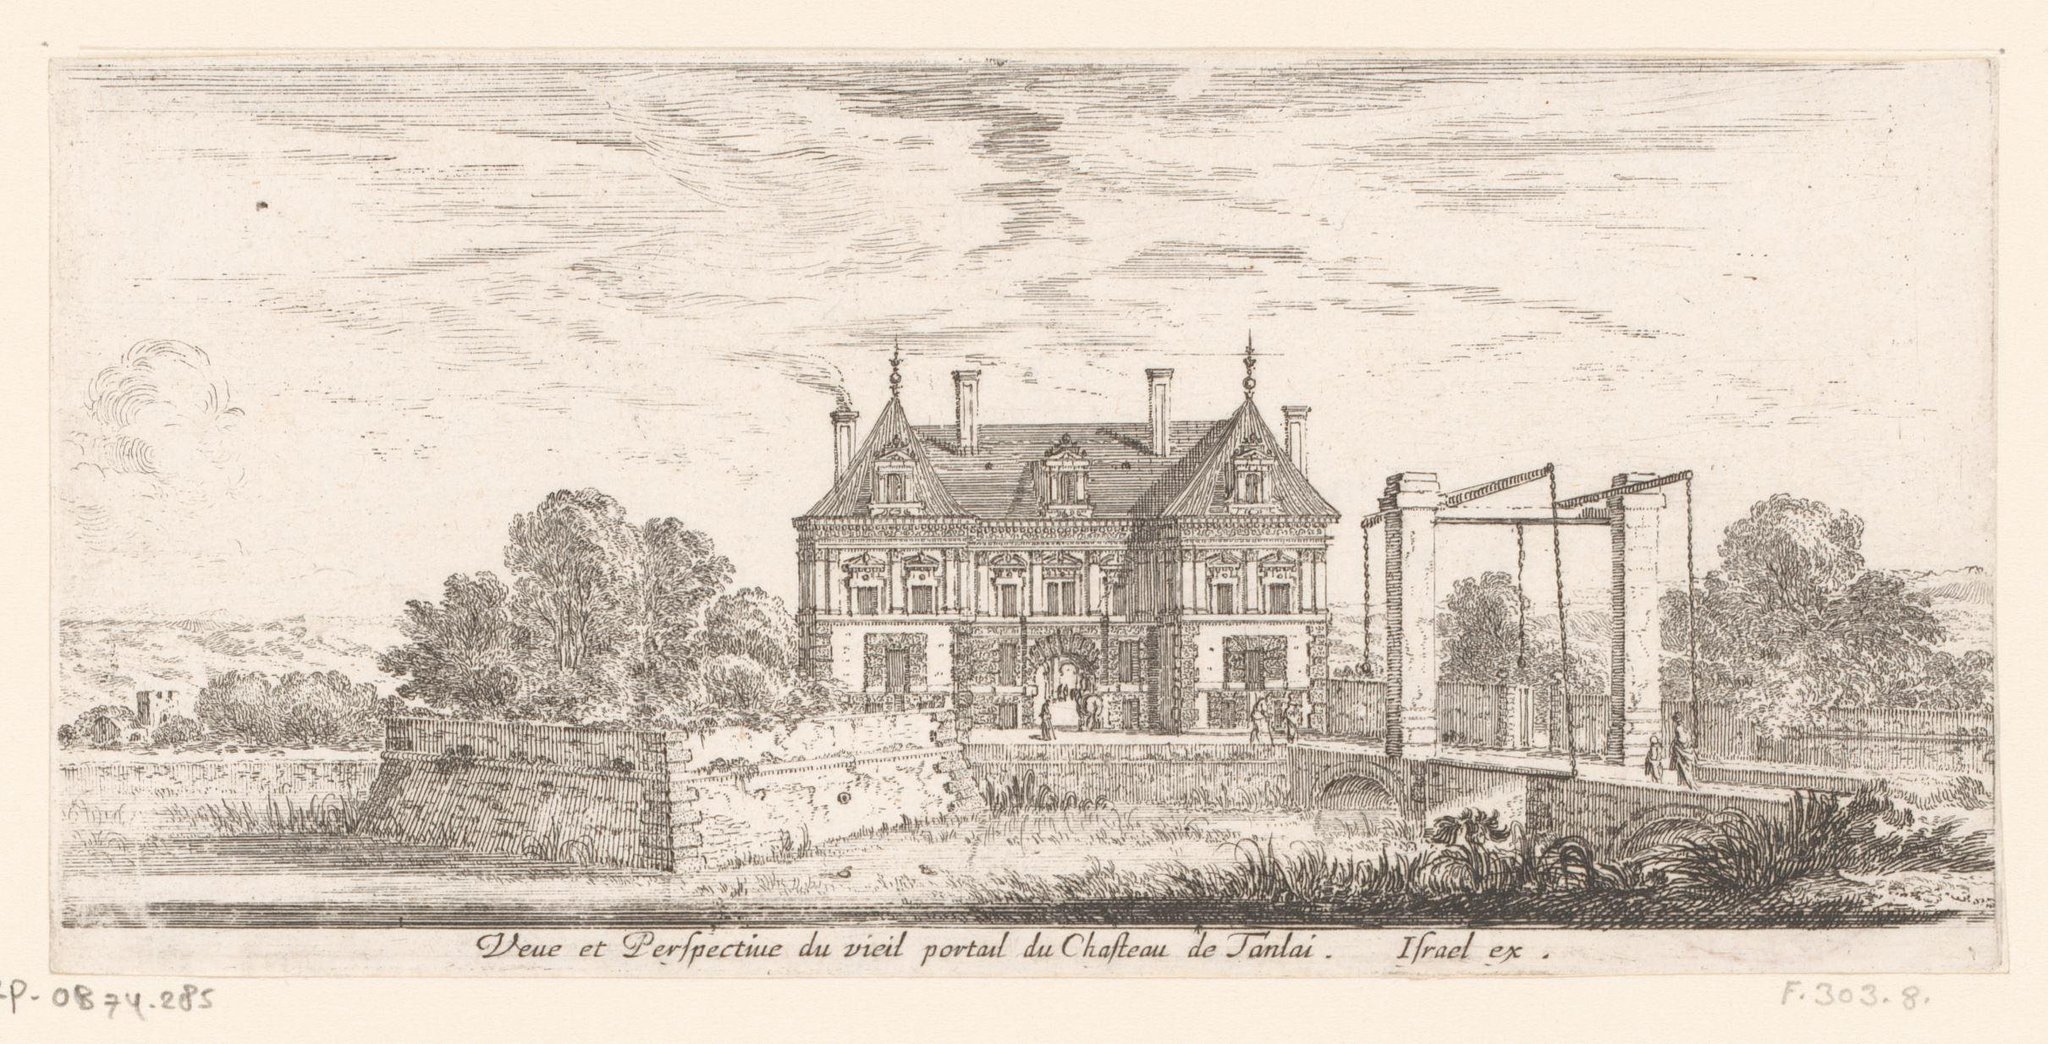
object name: print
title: Veue et Perspective du vieil portail du Chasteau de Tanlai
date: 1631-1661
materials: paper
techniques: etching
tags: city-view, and landscape with man-made constructions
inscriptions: collector's mark: Lugt 240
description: Prent maakt deel uit van een ongenummerde serie van negen prenten.